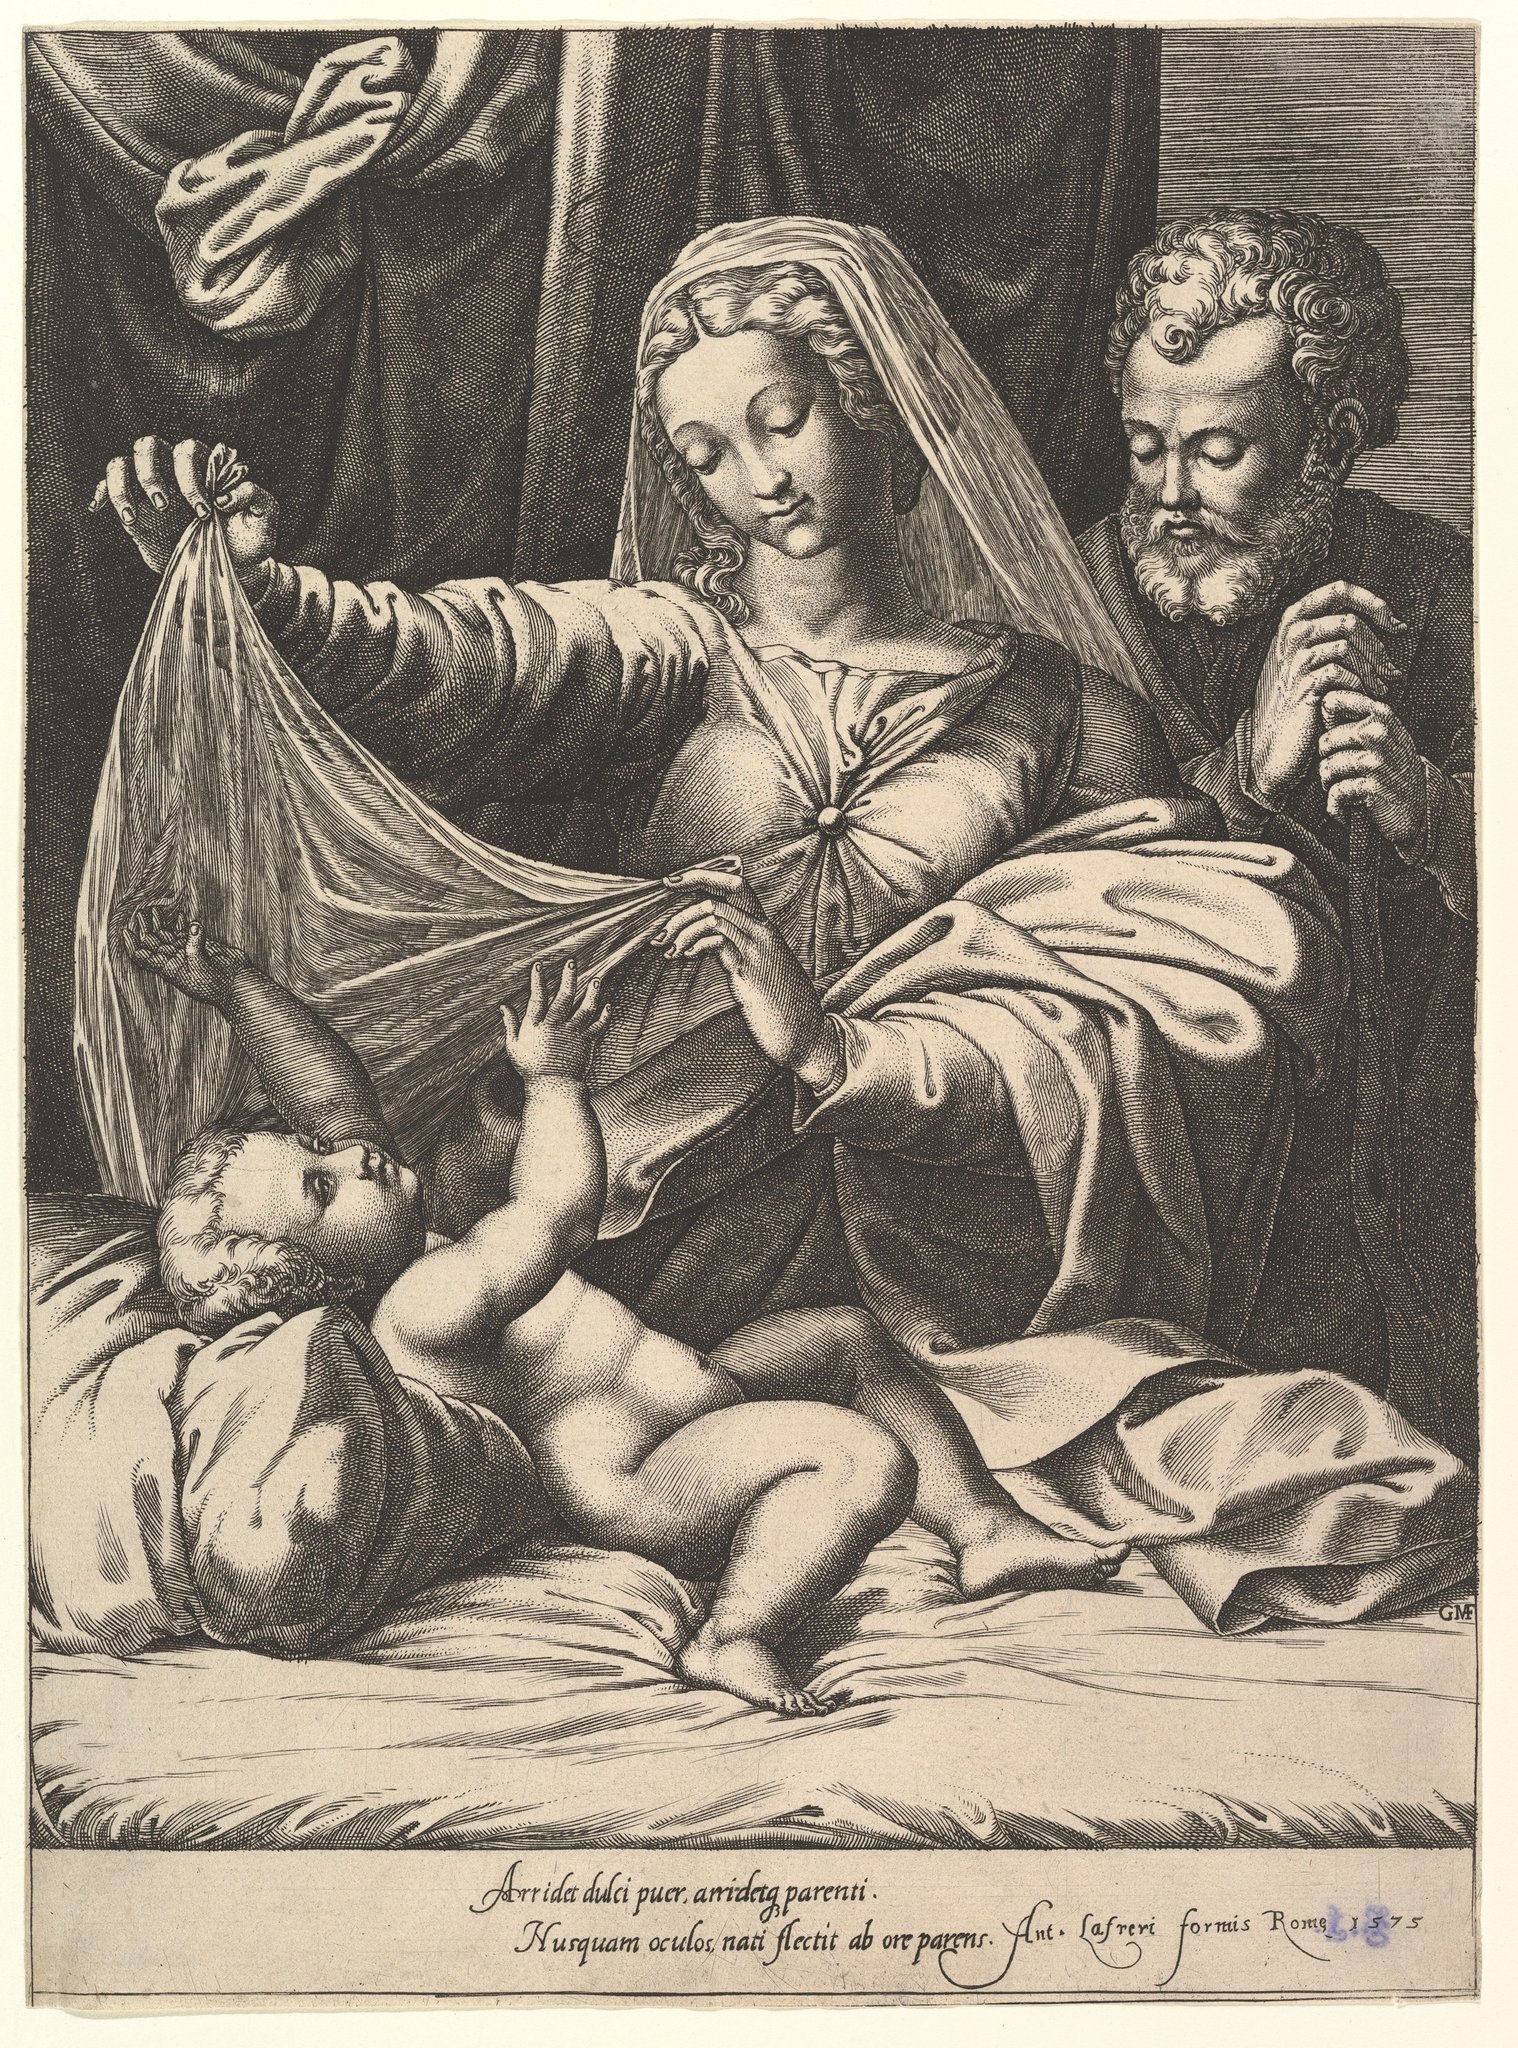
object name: print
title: Madonna of Loreto, the Virgin lifts a veil above the Child, who lies on a bed and pillow, Joseph stands behind with both hands on his staff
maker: giorgio ghisi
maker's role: artist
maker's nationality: italian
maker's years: 1515-1582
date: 1575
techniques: engraving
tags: christ,holy family,saint joseph,virgin mary